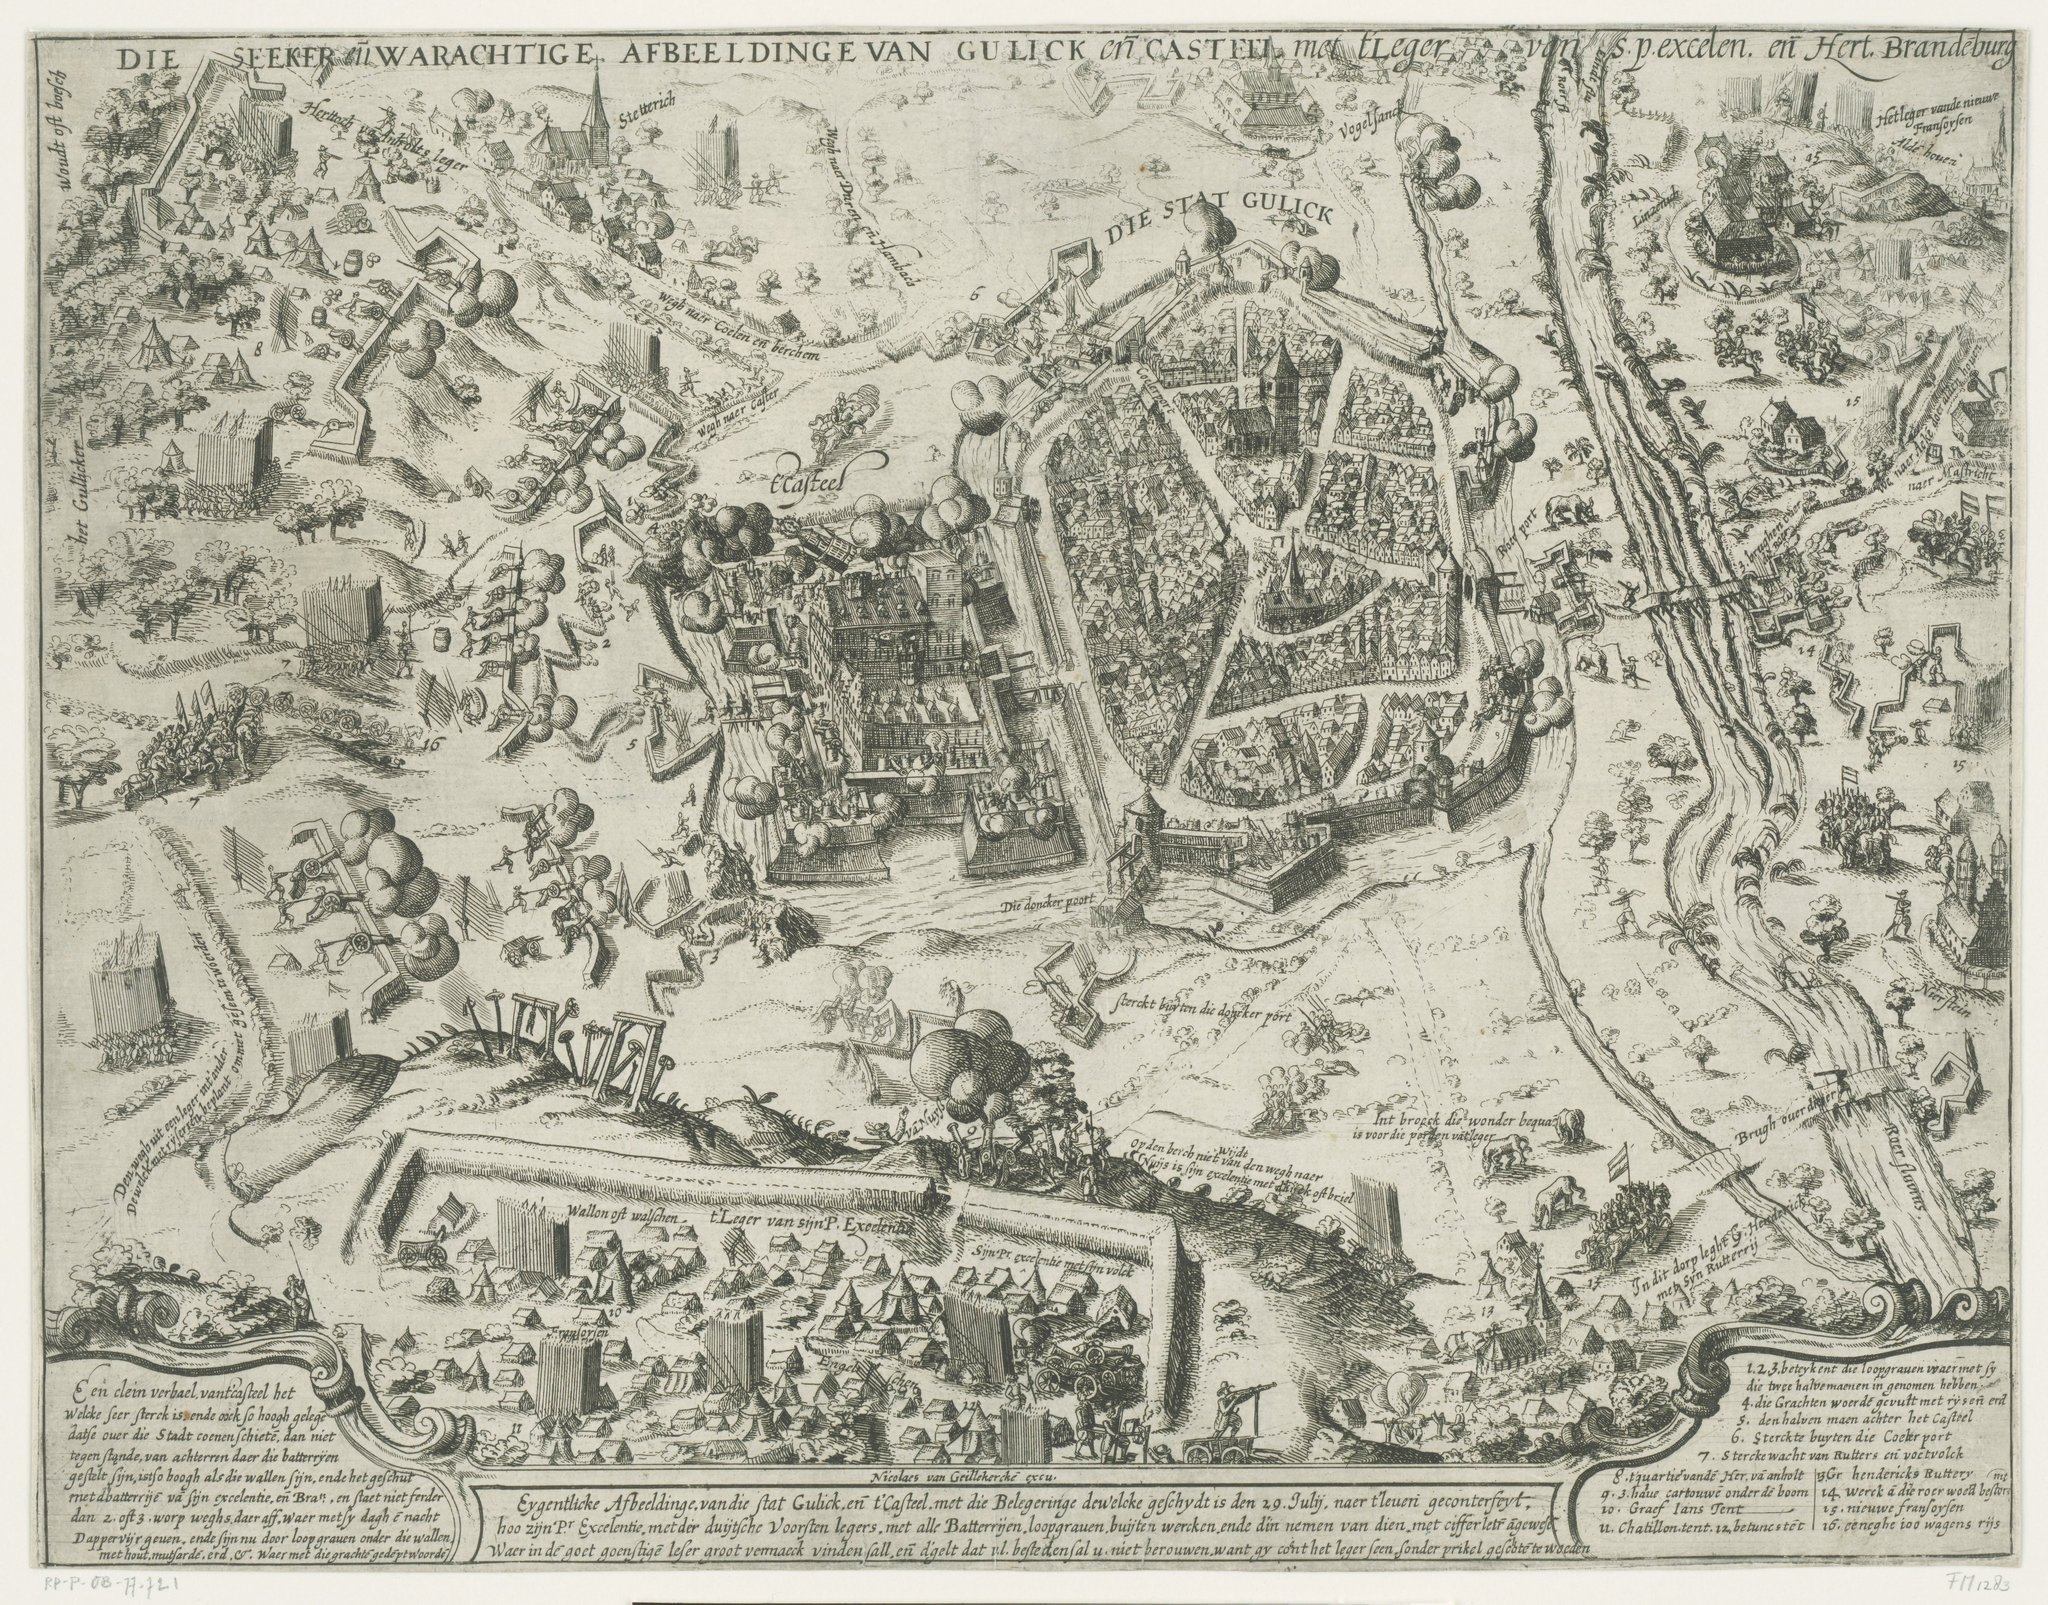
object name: print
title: Het beleg van Gulik, 1610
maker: nicolaes van geelkercken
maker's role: print maker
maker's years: 1585-1656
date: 1610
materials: paper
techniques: engraving, etching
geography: northern netherlands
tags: the hague, maurice (prince of orange), siege, position war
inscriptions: title: ‘Die seeker warachtige afbeeldinge van Gulick en Casteel met t; Leger van ....Brandenburg’, address: ‘Nicolaes van Geillekercke excu.’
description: Gezicht op de belegering van de stad Gulik door de legers van de vorst van Anhalt en prins Maurits, aangevangen 29 juli 1610. In het midden de stad met het kasteel, rechts de rivier de Ruhr. Onderaan het kamp van prins Maurits, linksboven het kwartier van de vorst van Anhalt. Onderaan cartouches met teksten en de legenda 1-16 in het Nederlands.